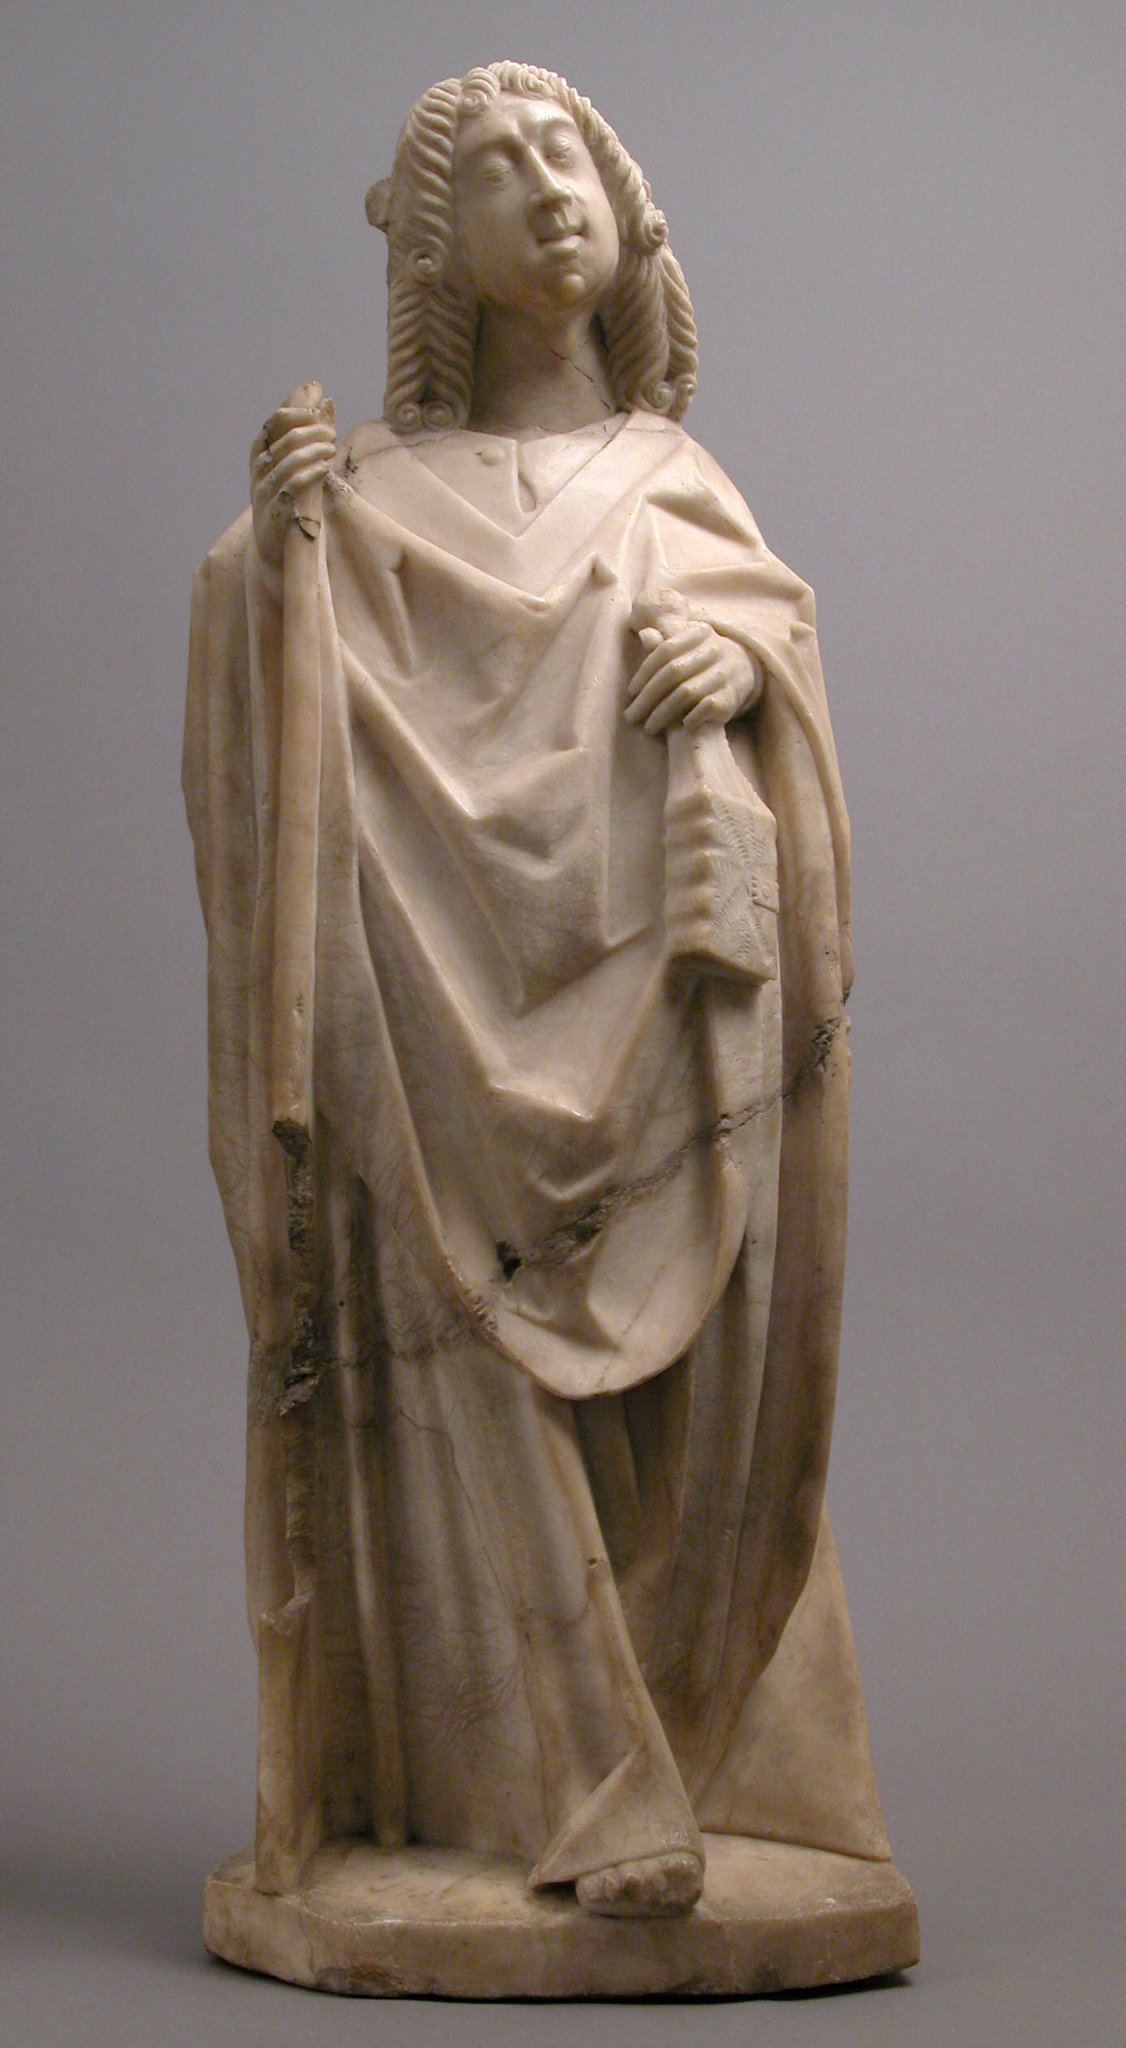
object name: statuette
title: Apostle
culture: spanish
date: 1401-1600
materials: alabaster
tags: men